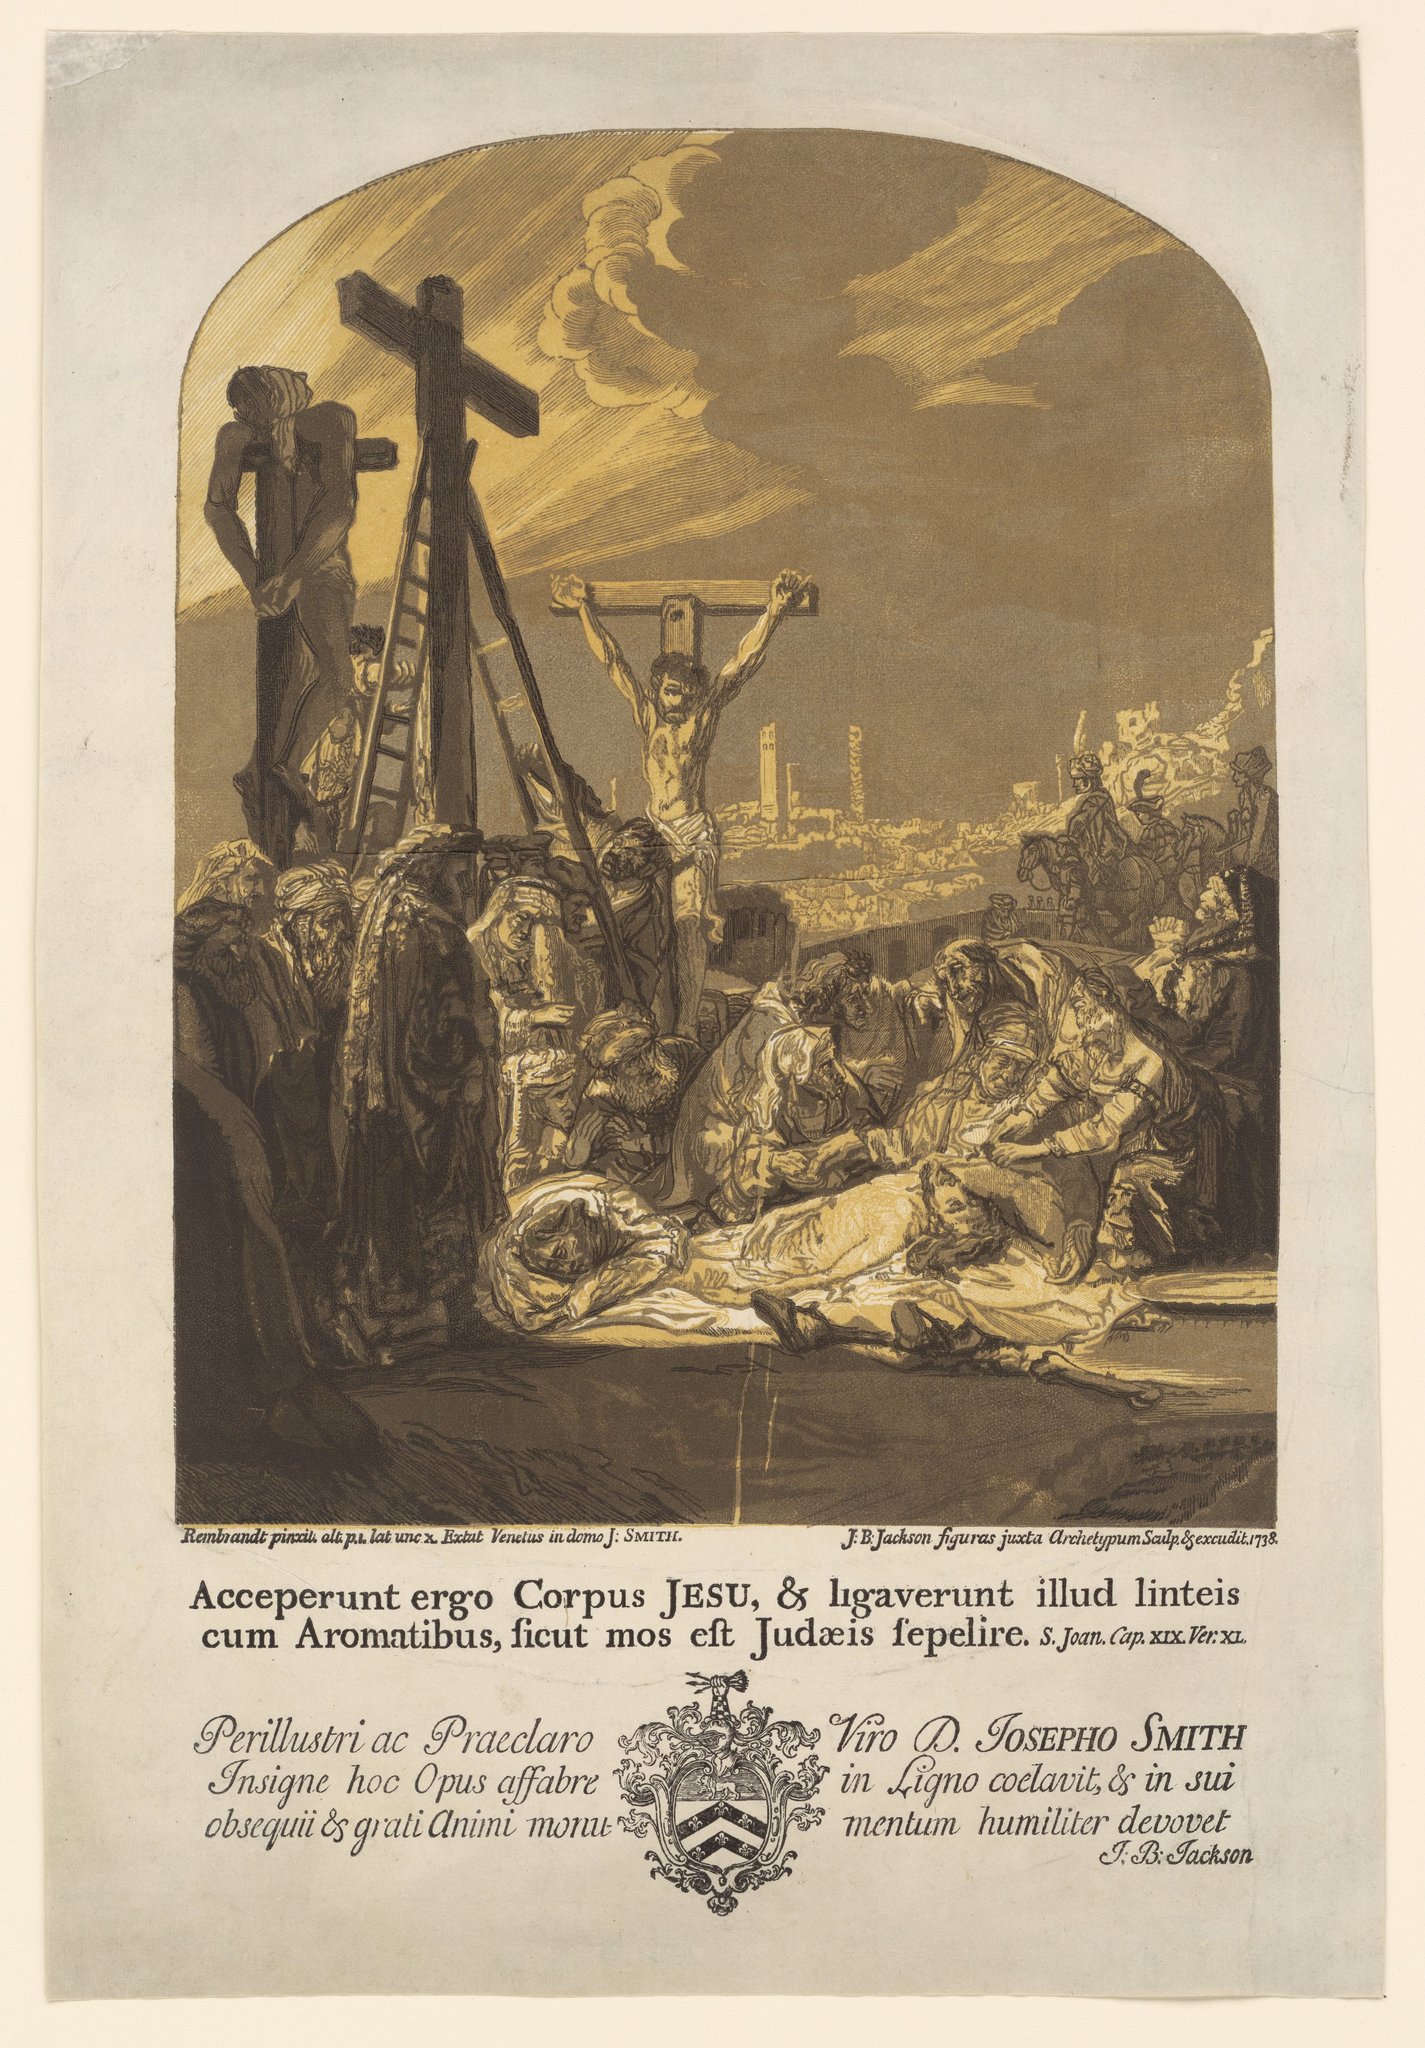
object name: print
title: Acceperunt ergo corpus Jesu (...) Judaeis fepelire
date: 1738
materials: paper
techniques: woodcut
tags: lamentation over the dead christ by his relatives and friends (christ usually without crown of thorns)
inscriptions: collector's mark: Lugt 2760, collector's mark: Lugt 2228